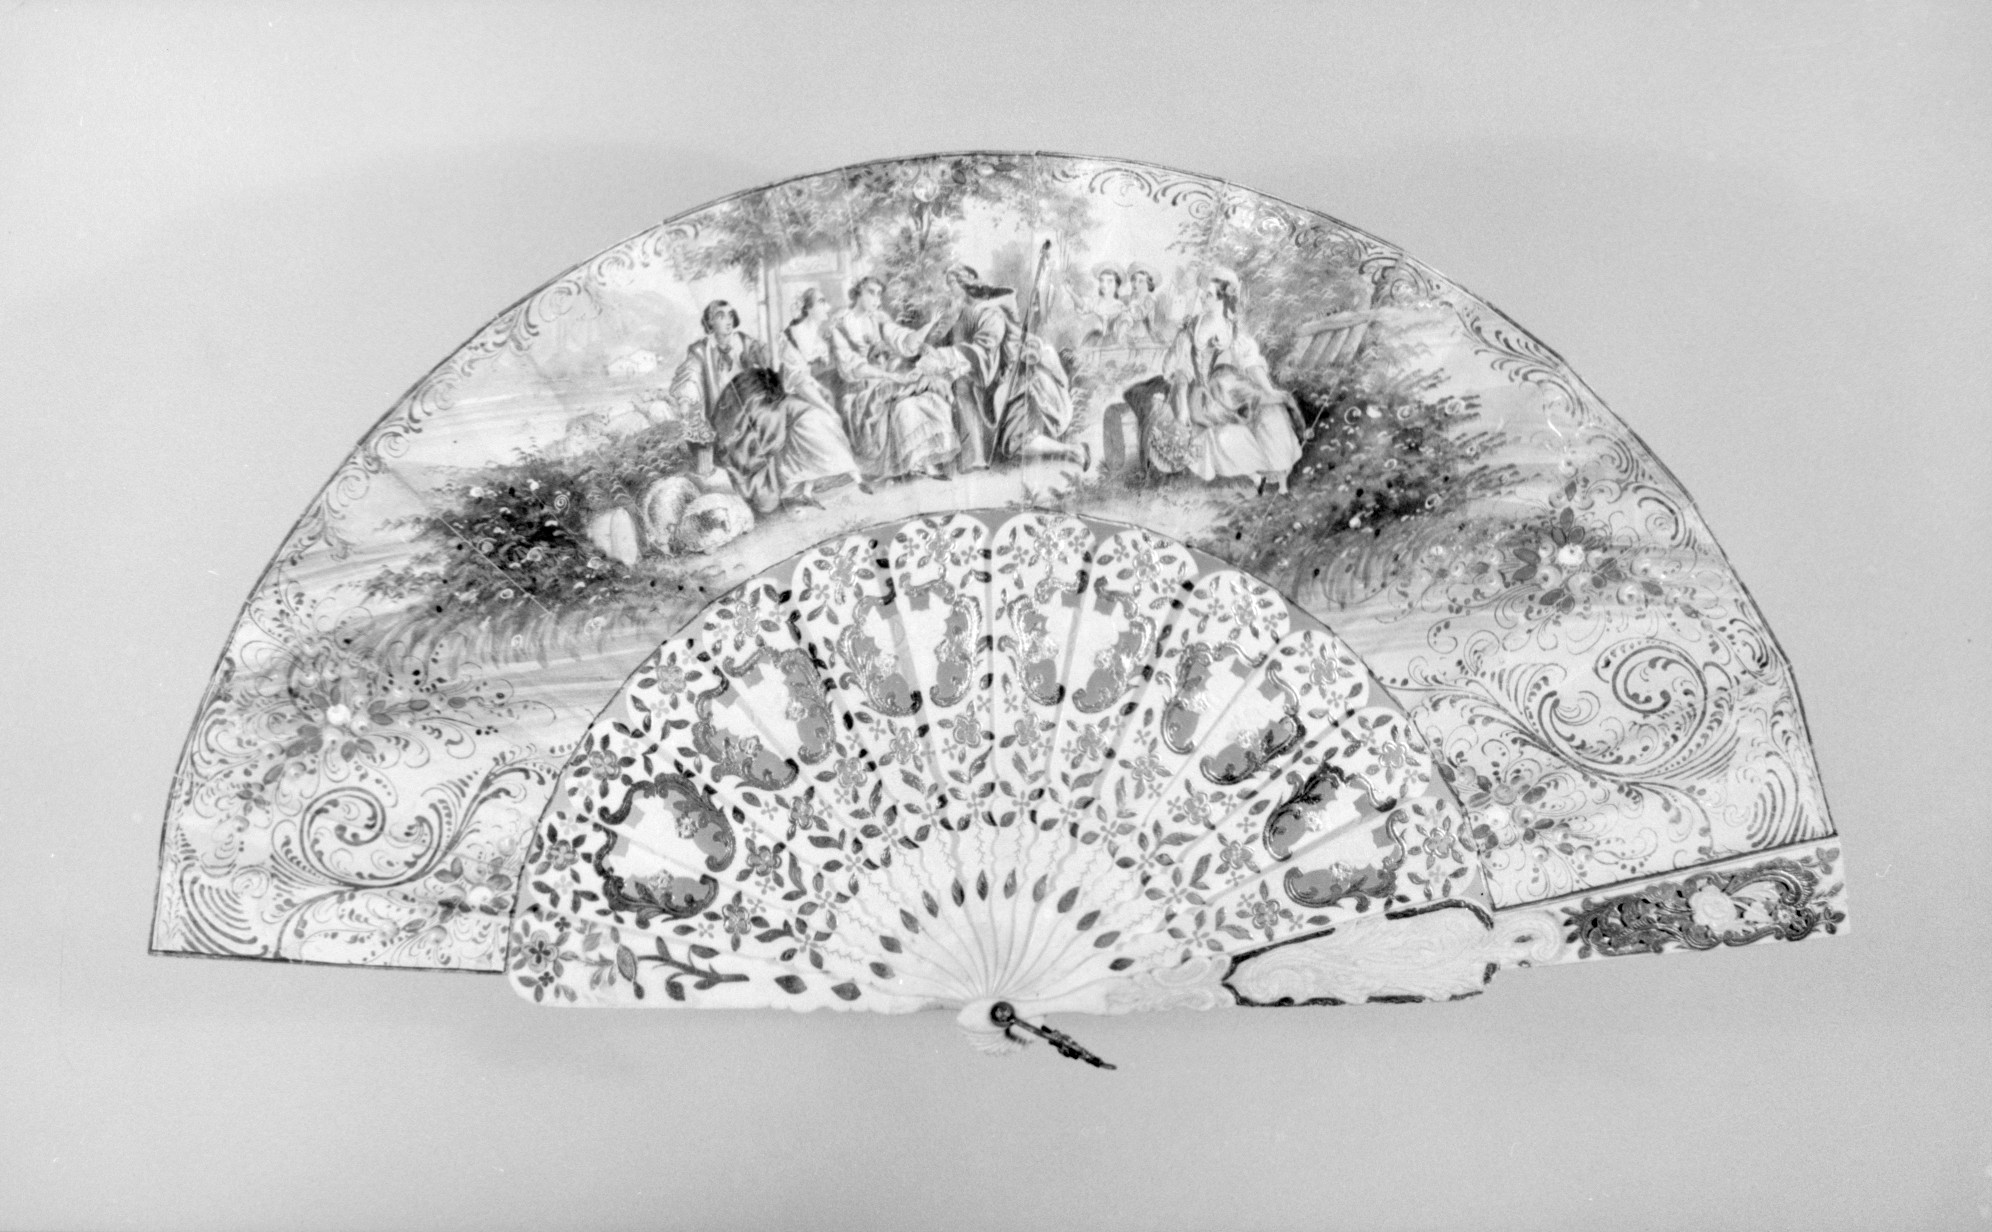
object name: fan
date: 1834-1866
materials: gilt, glass, gold, ivory, metal, paint, paper, silver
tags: men,women